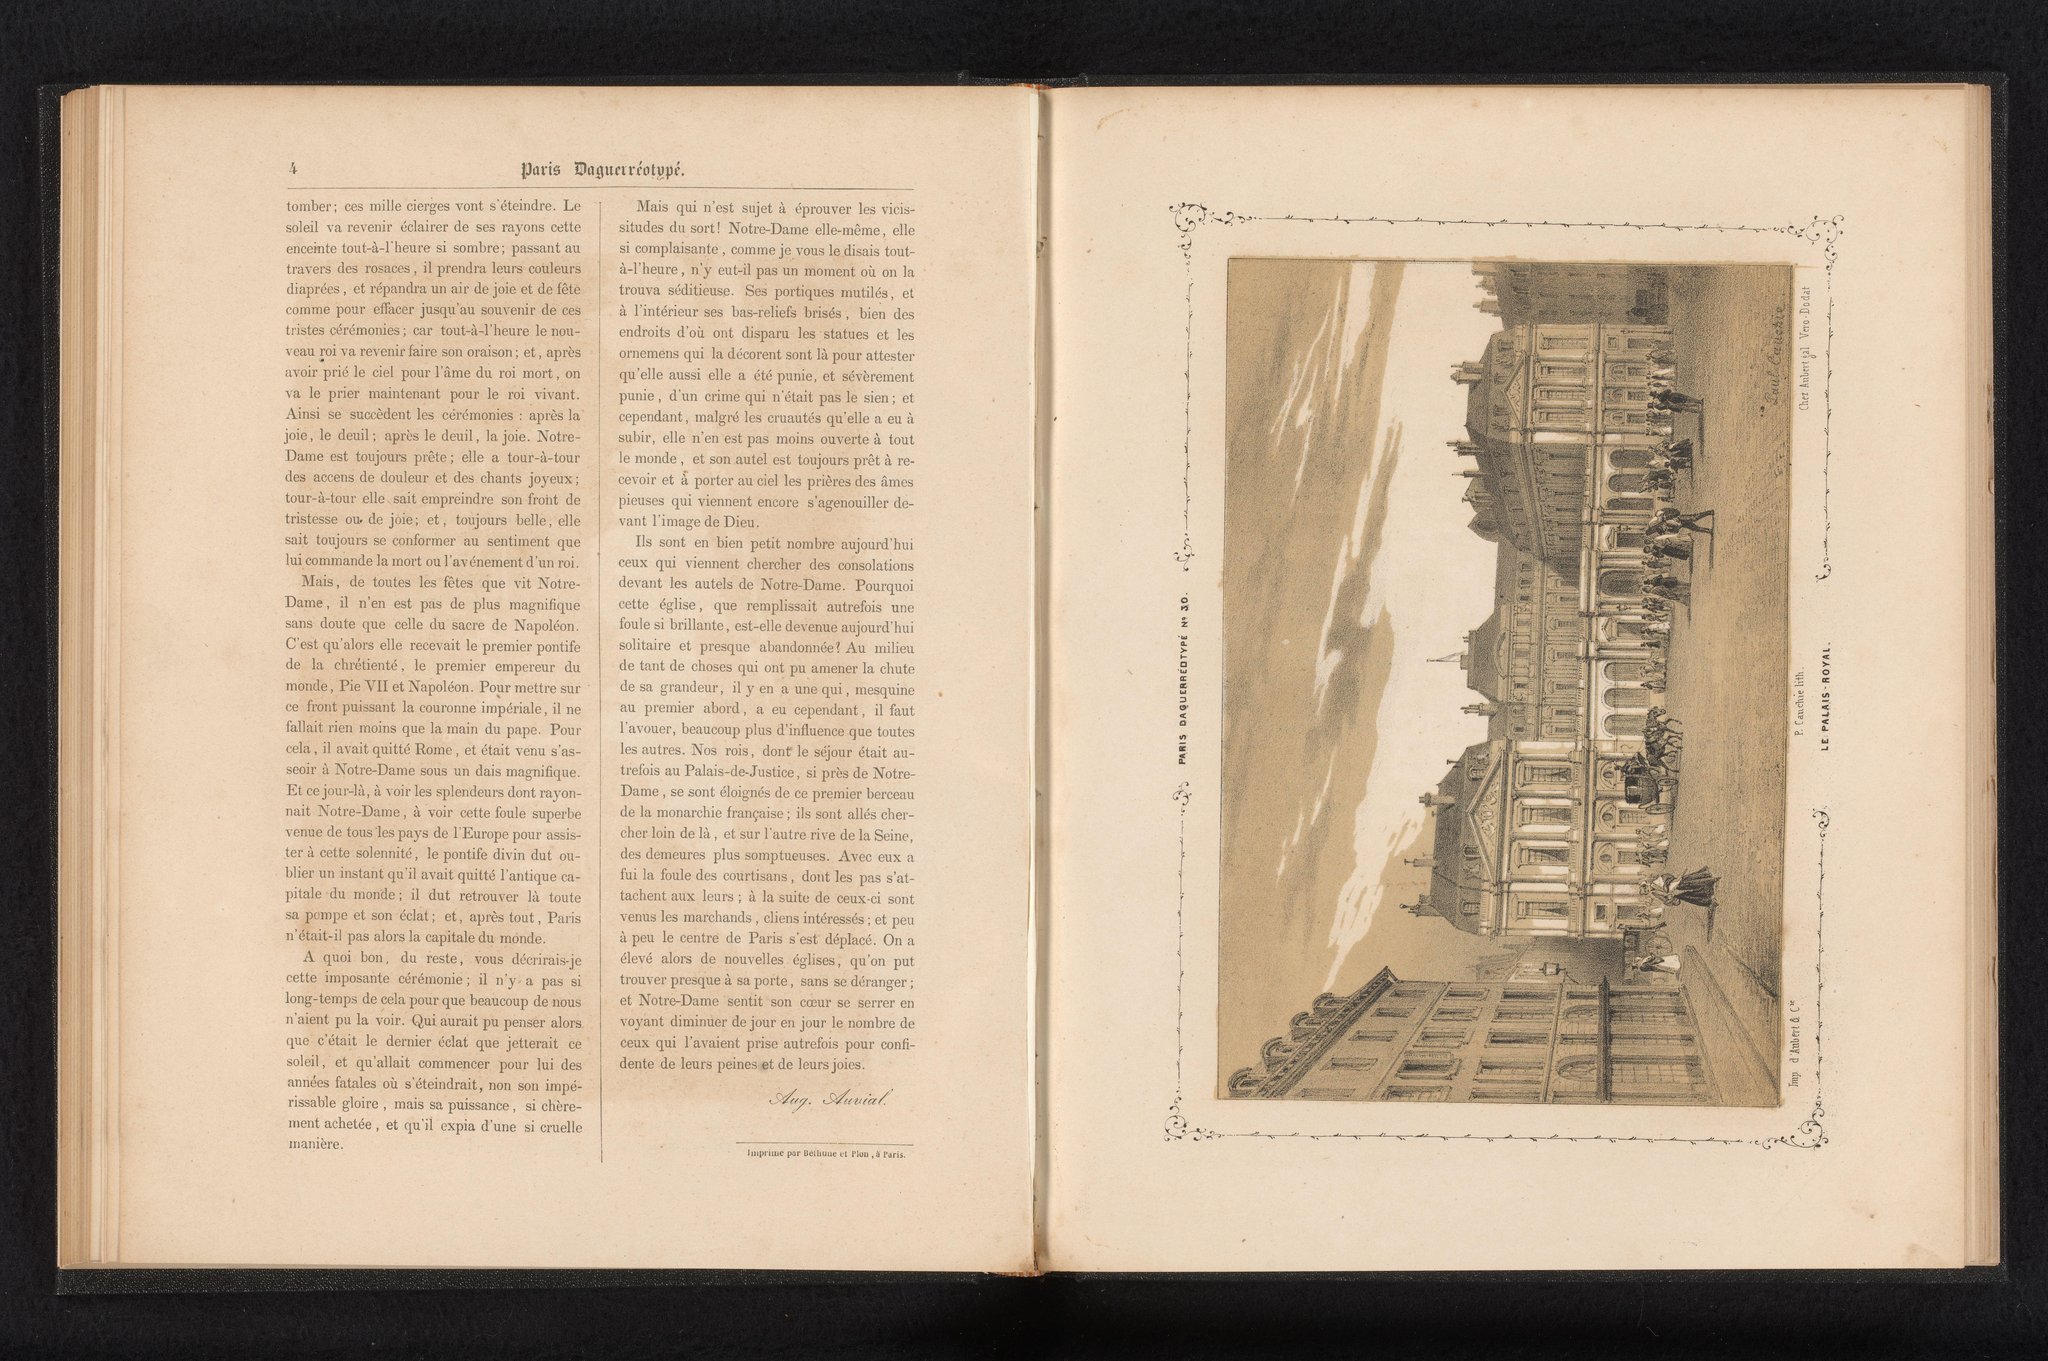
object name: page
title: Le Palais-Royal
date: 1839-1840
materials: paper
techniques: tone lithography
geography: paris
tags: palace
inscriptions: inscription: ‘PARIS DAGUERRÉOTYPÉ No. 30.’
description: Prent op honderdnegentiende ongenummerde pagina.